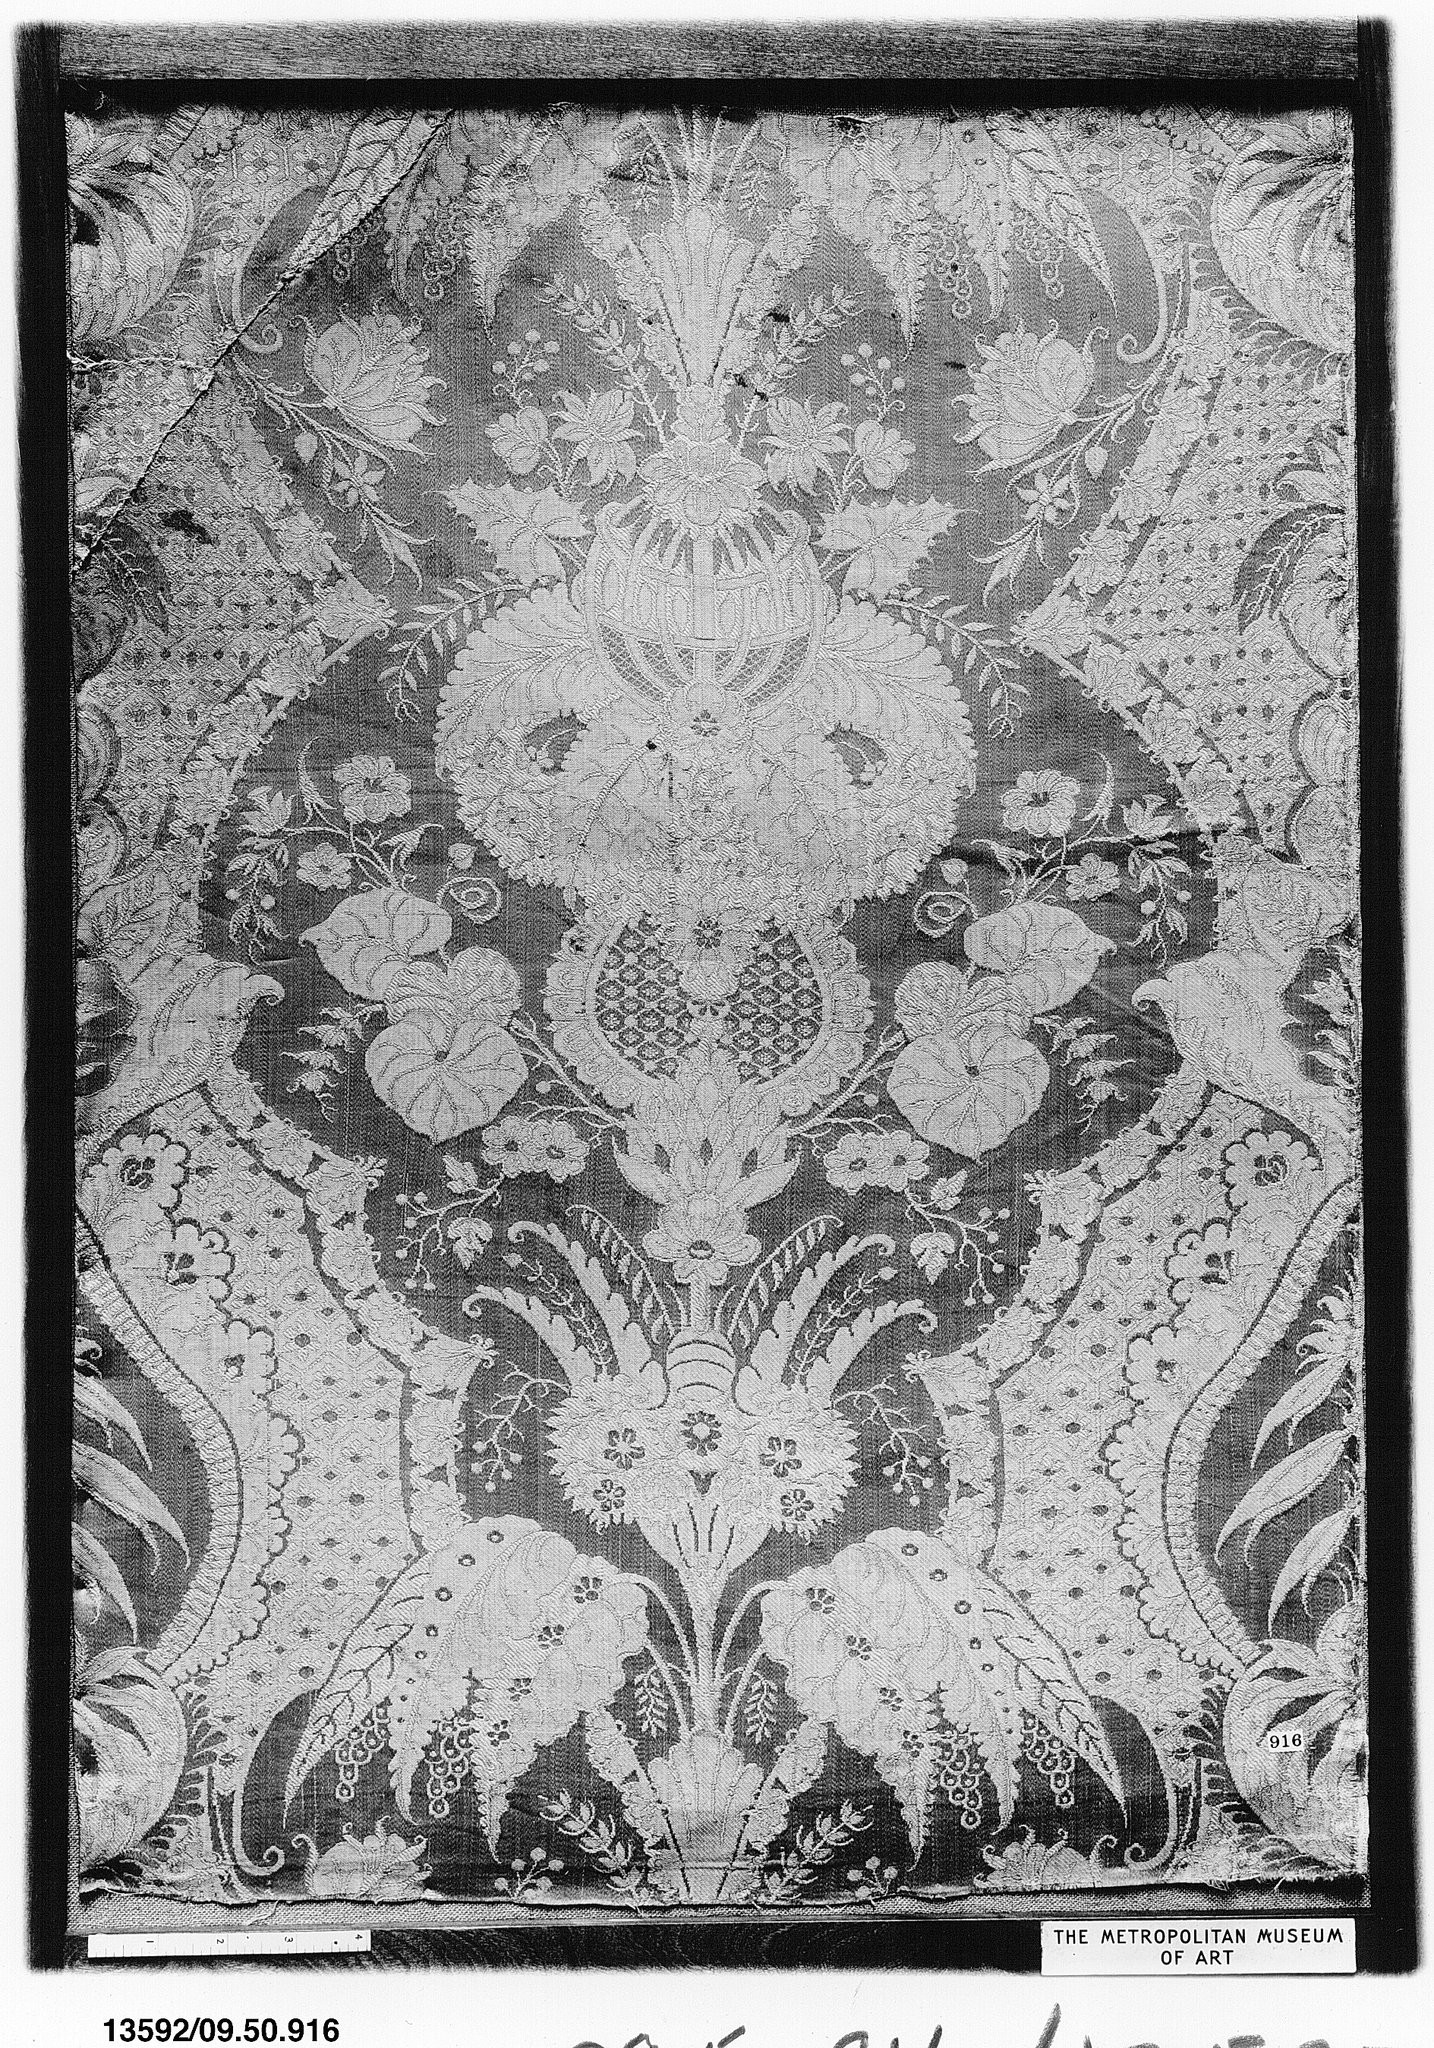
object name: piece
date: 1730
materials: silk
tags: flowers,leaves